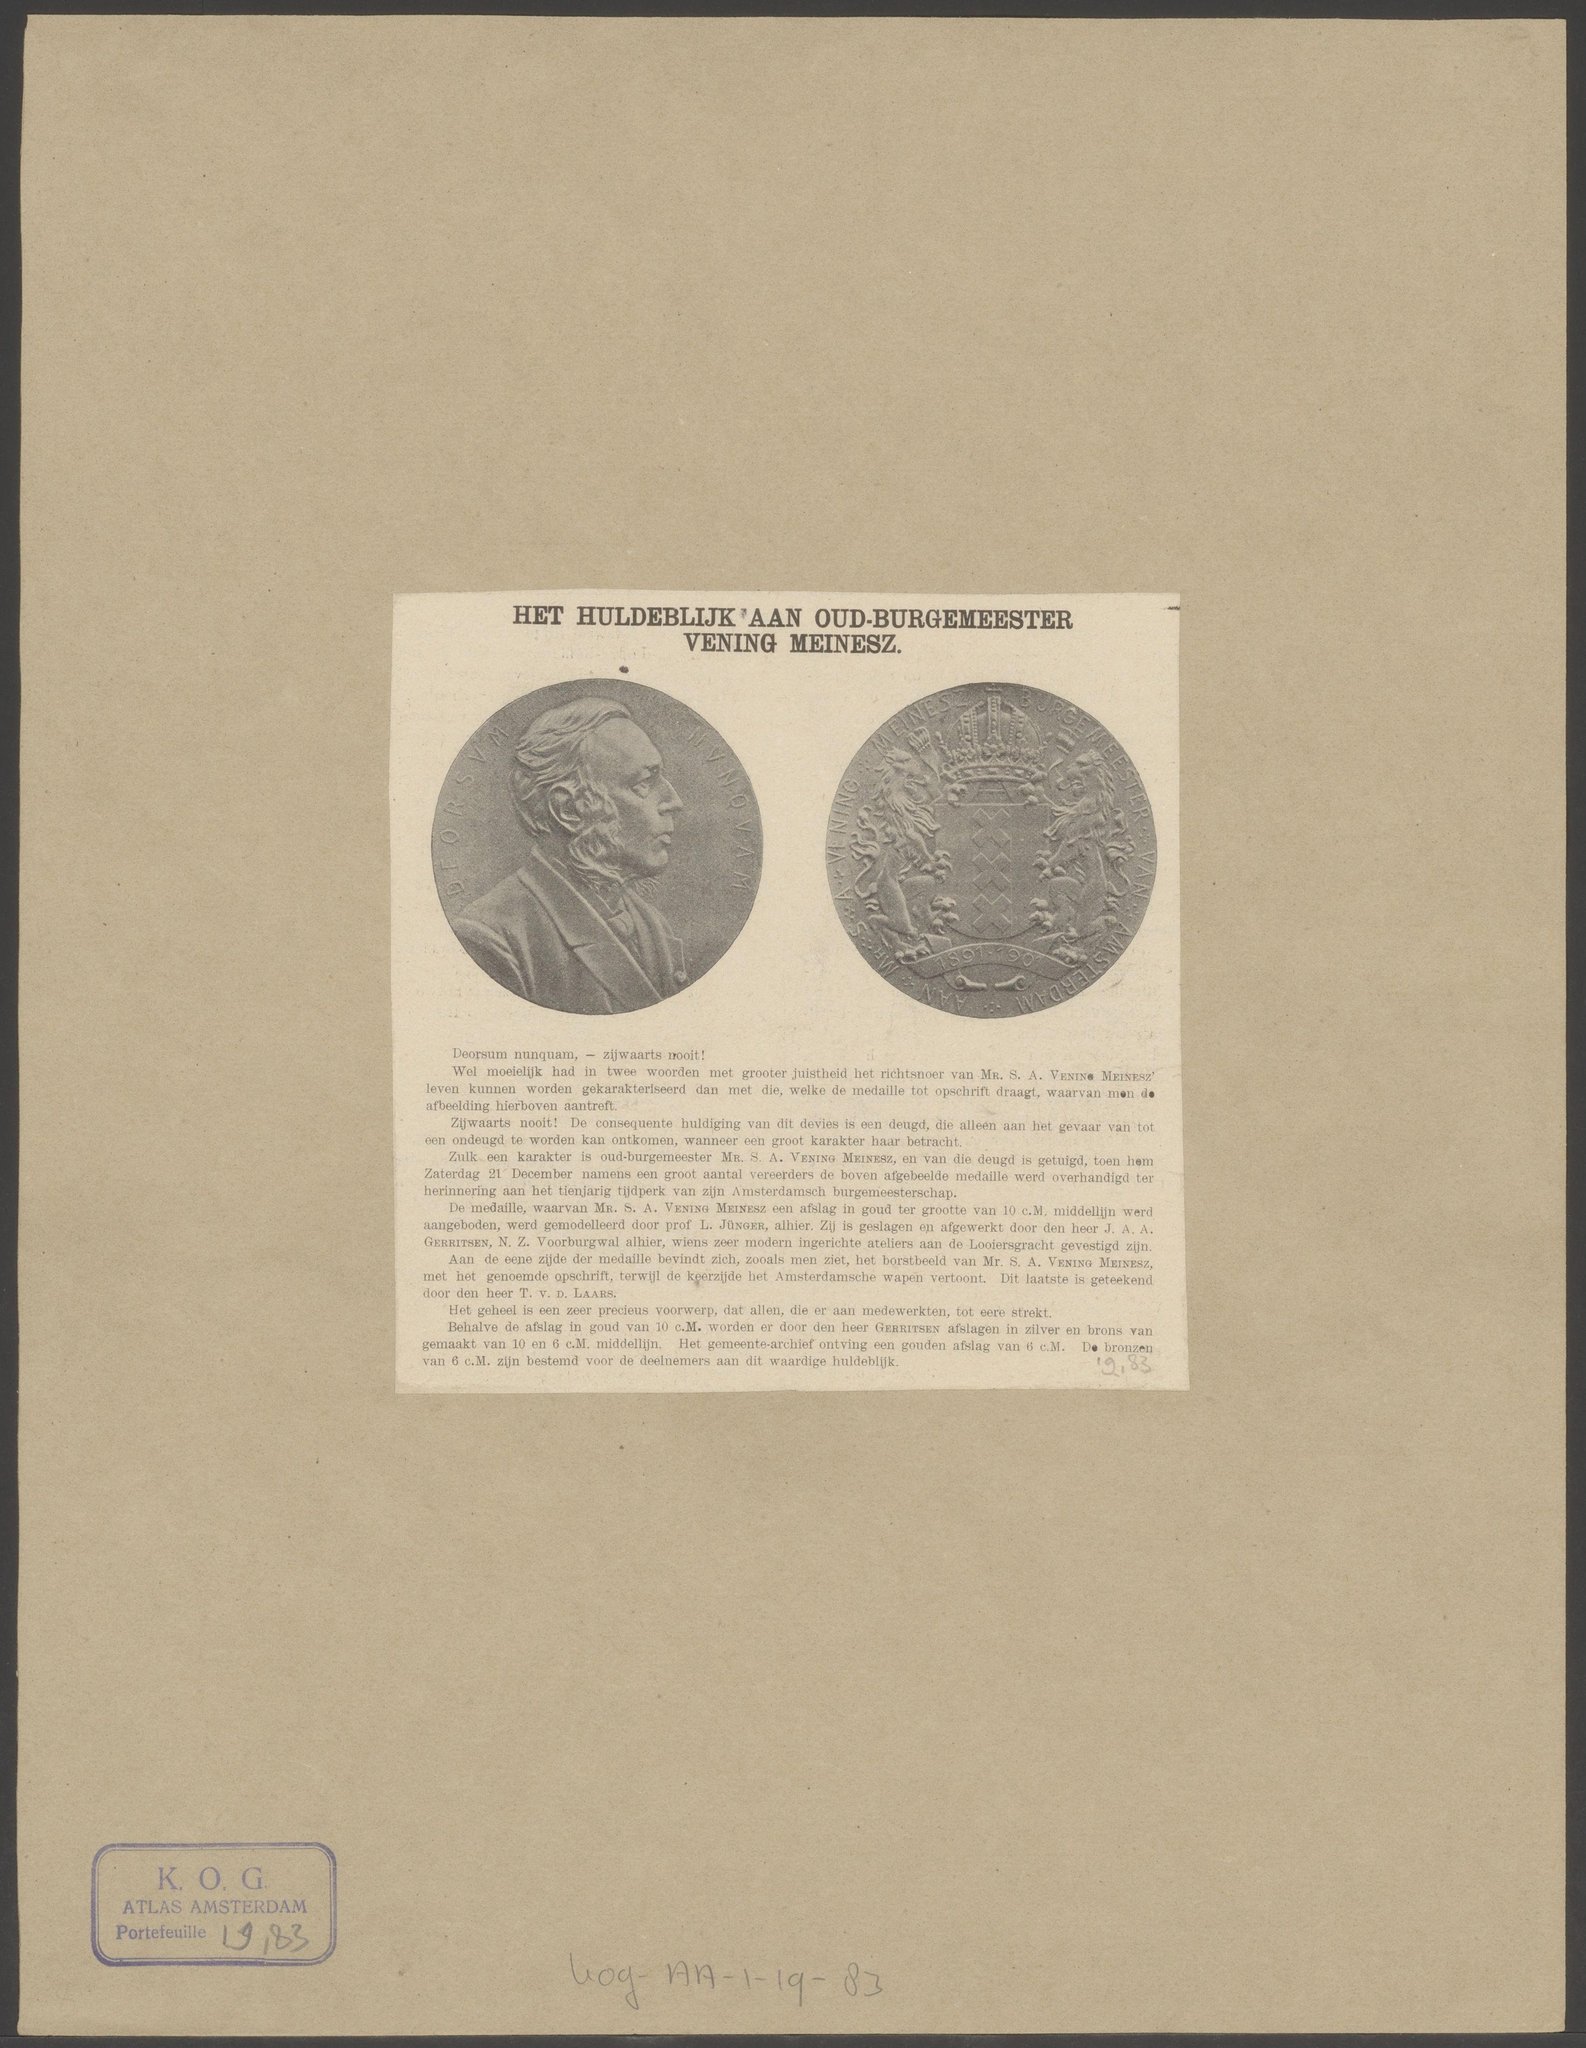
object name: medal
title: Voor- en achterzijde van een penning met het portret van Sjoerd Vening Meinesz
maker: Anonymous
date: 1901-1950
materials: paper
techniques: letterpress printing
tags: harlingen, politician, mayor, burgomaster, historical persons, amsterdam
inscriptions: collector's mark: ‘19,83’ Lugt 1641b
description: Onderwerpsrubriek binnen de Atlas Amsterdam: Herinneringen aan regeringsleden en hunne huisgezinnen [na 1800].